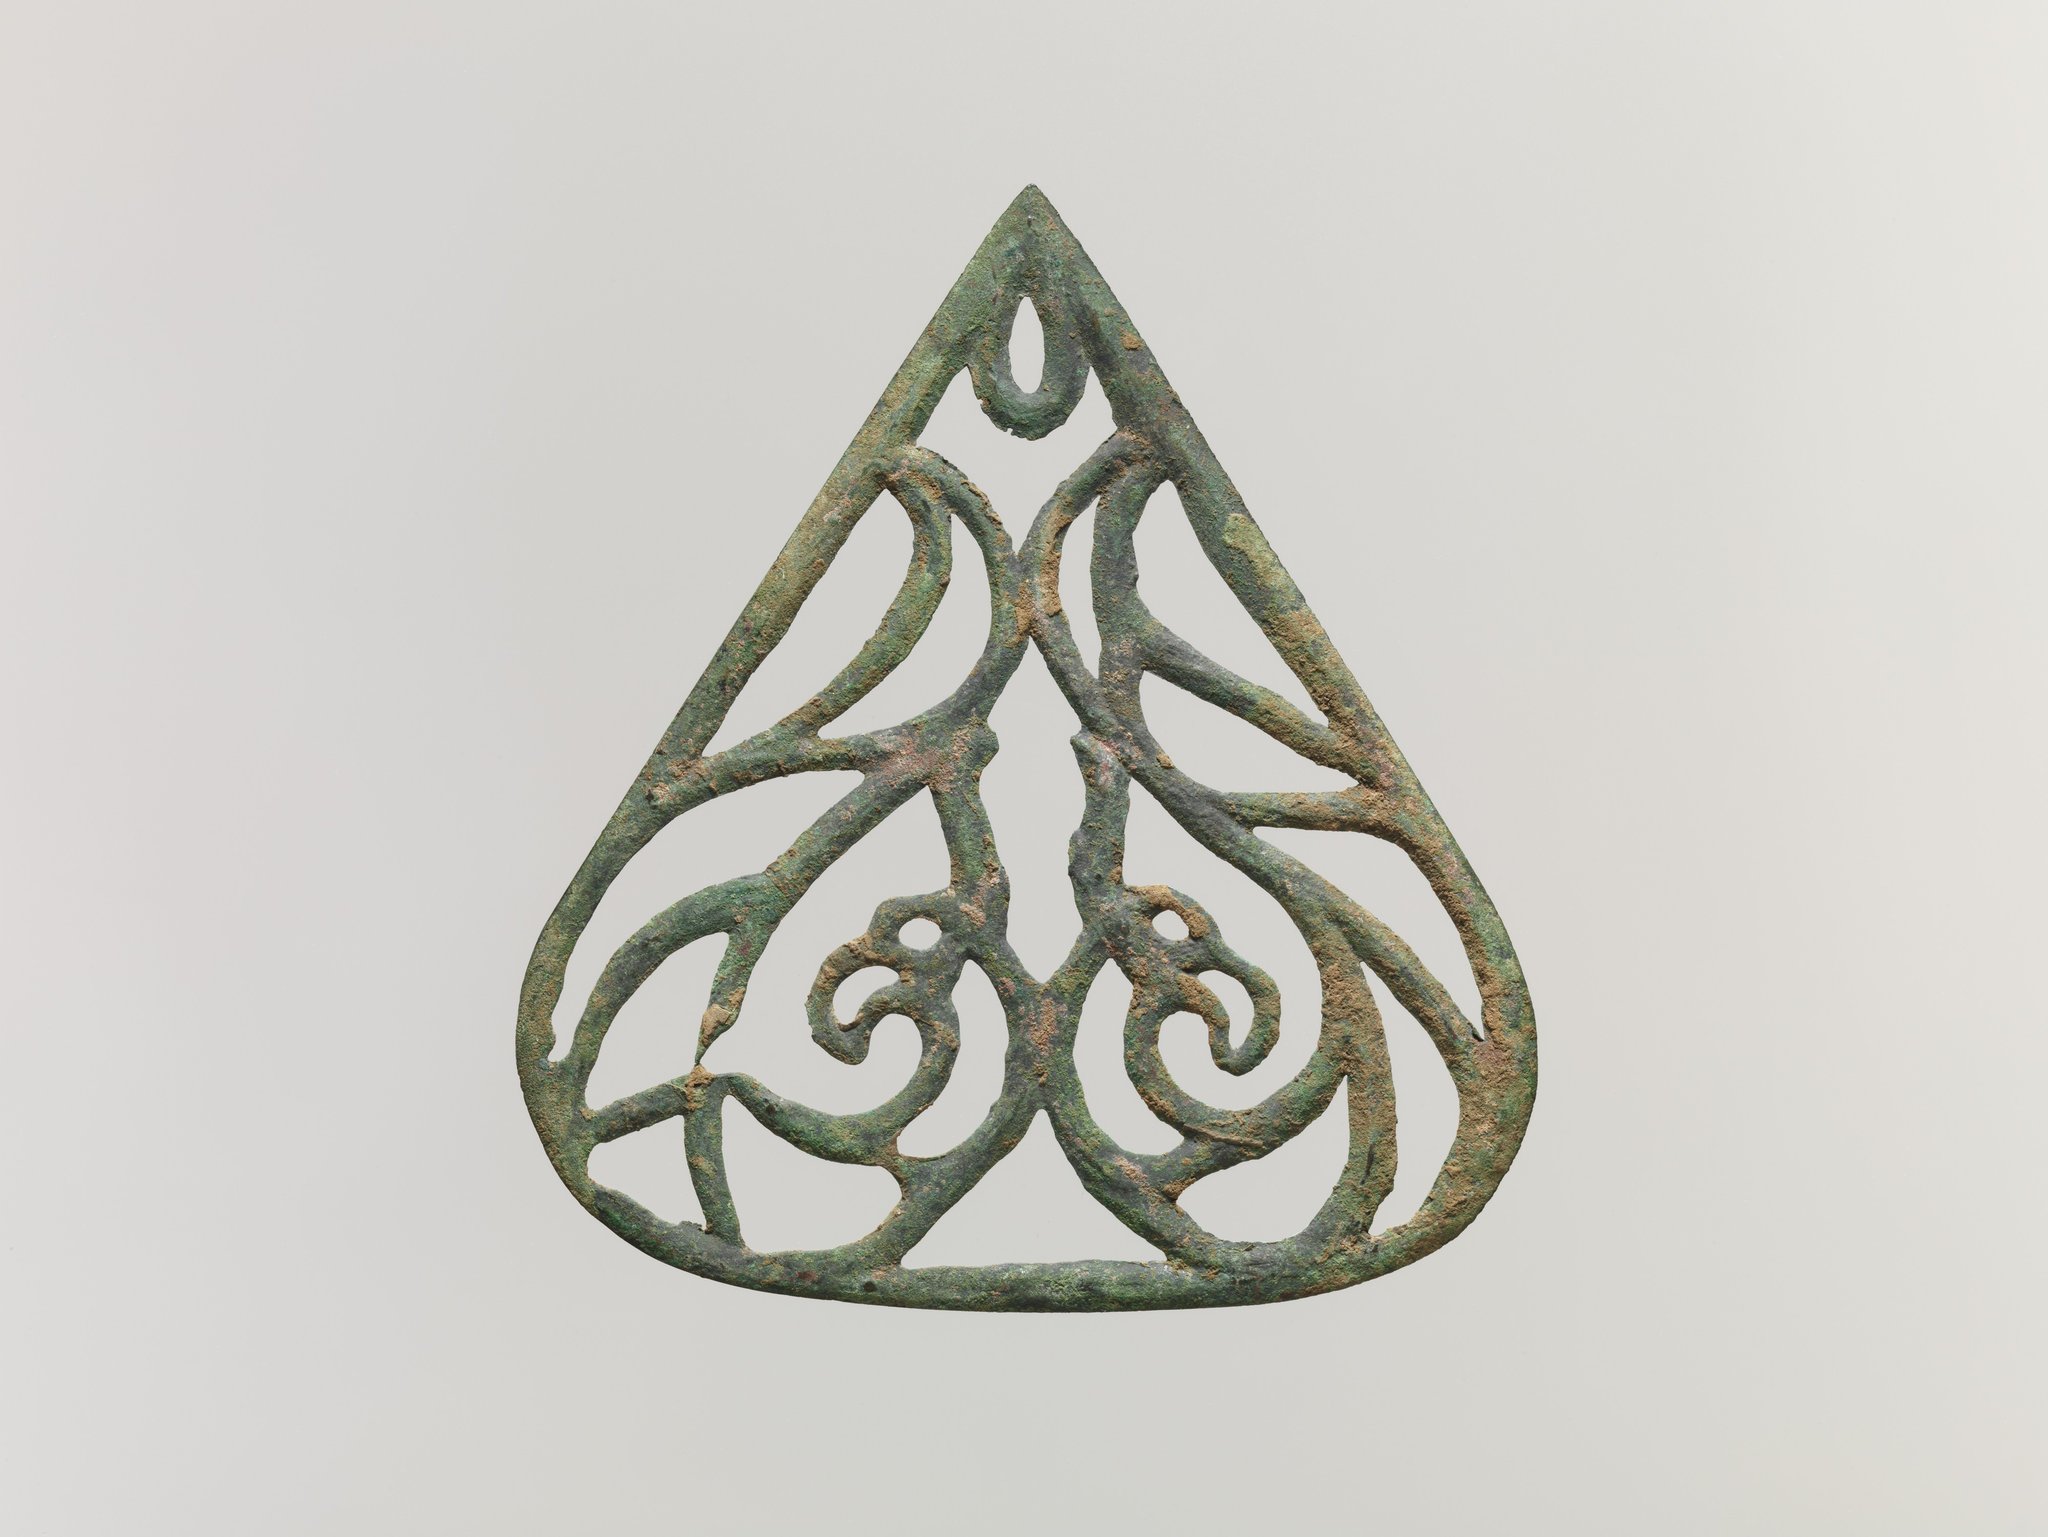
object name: harness trapping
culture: chinese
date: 500-401 BCE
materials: bronze, tin